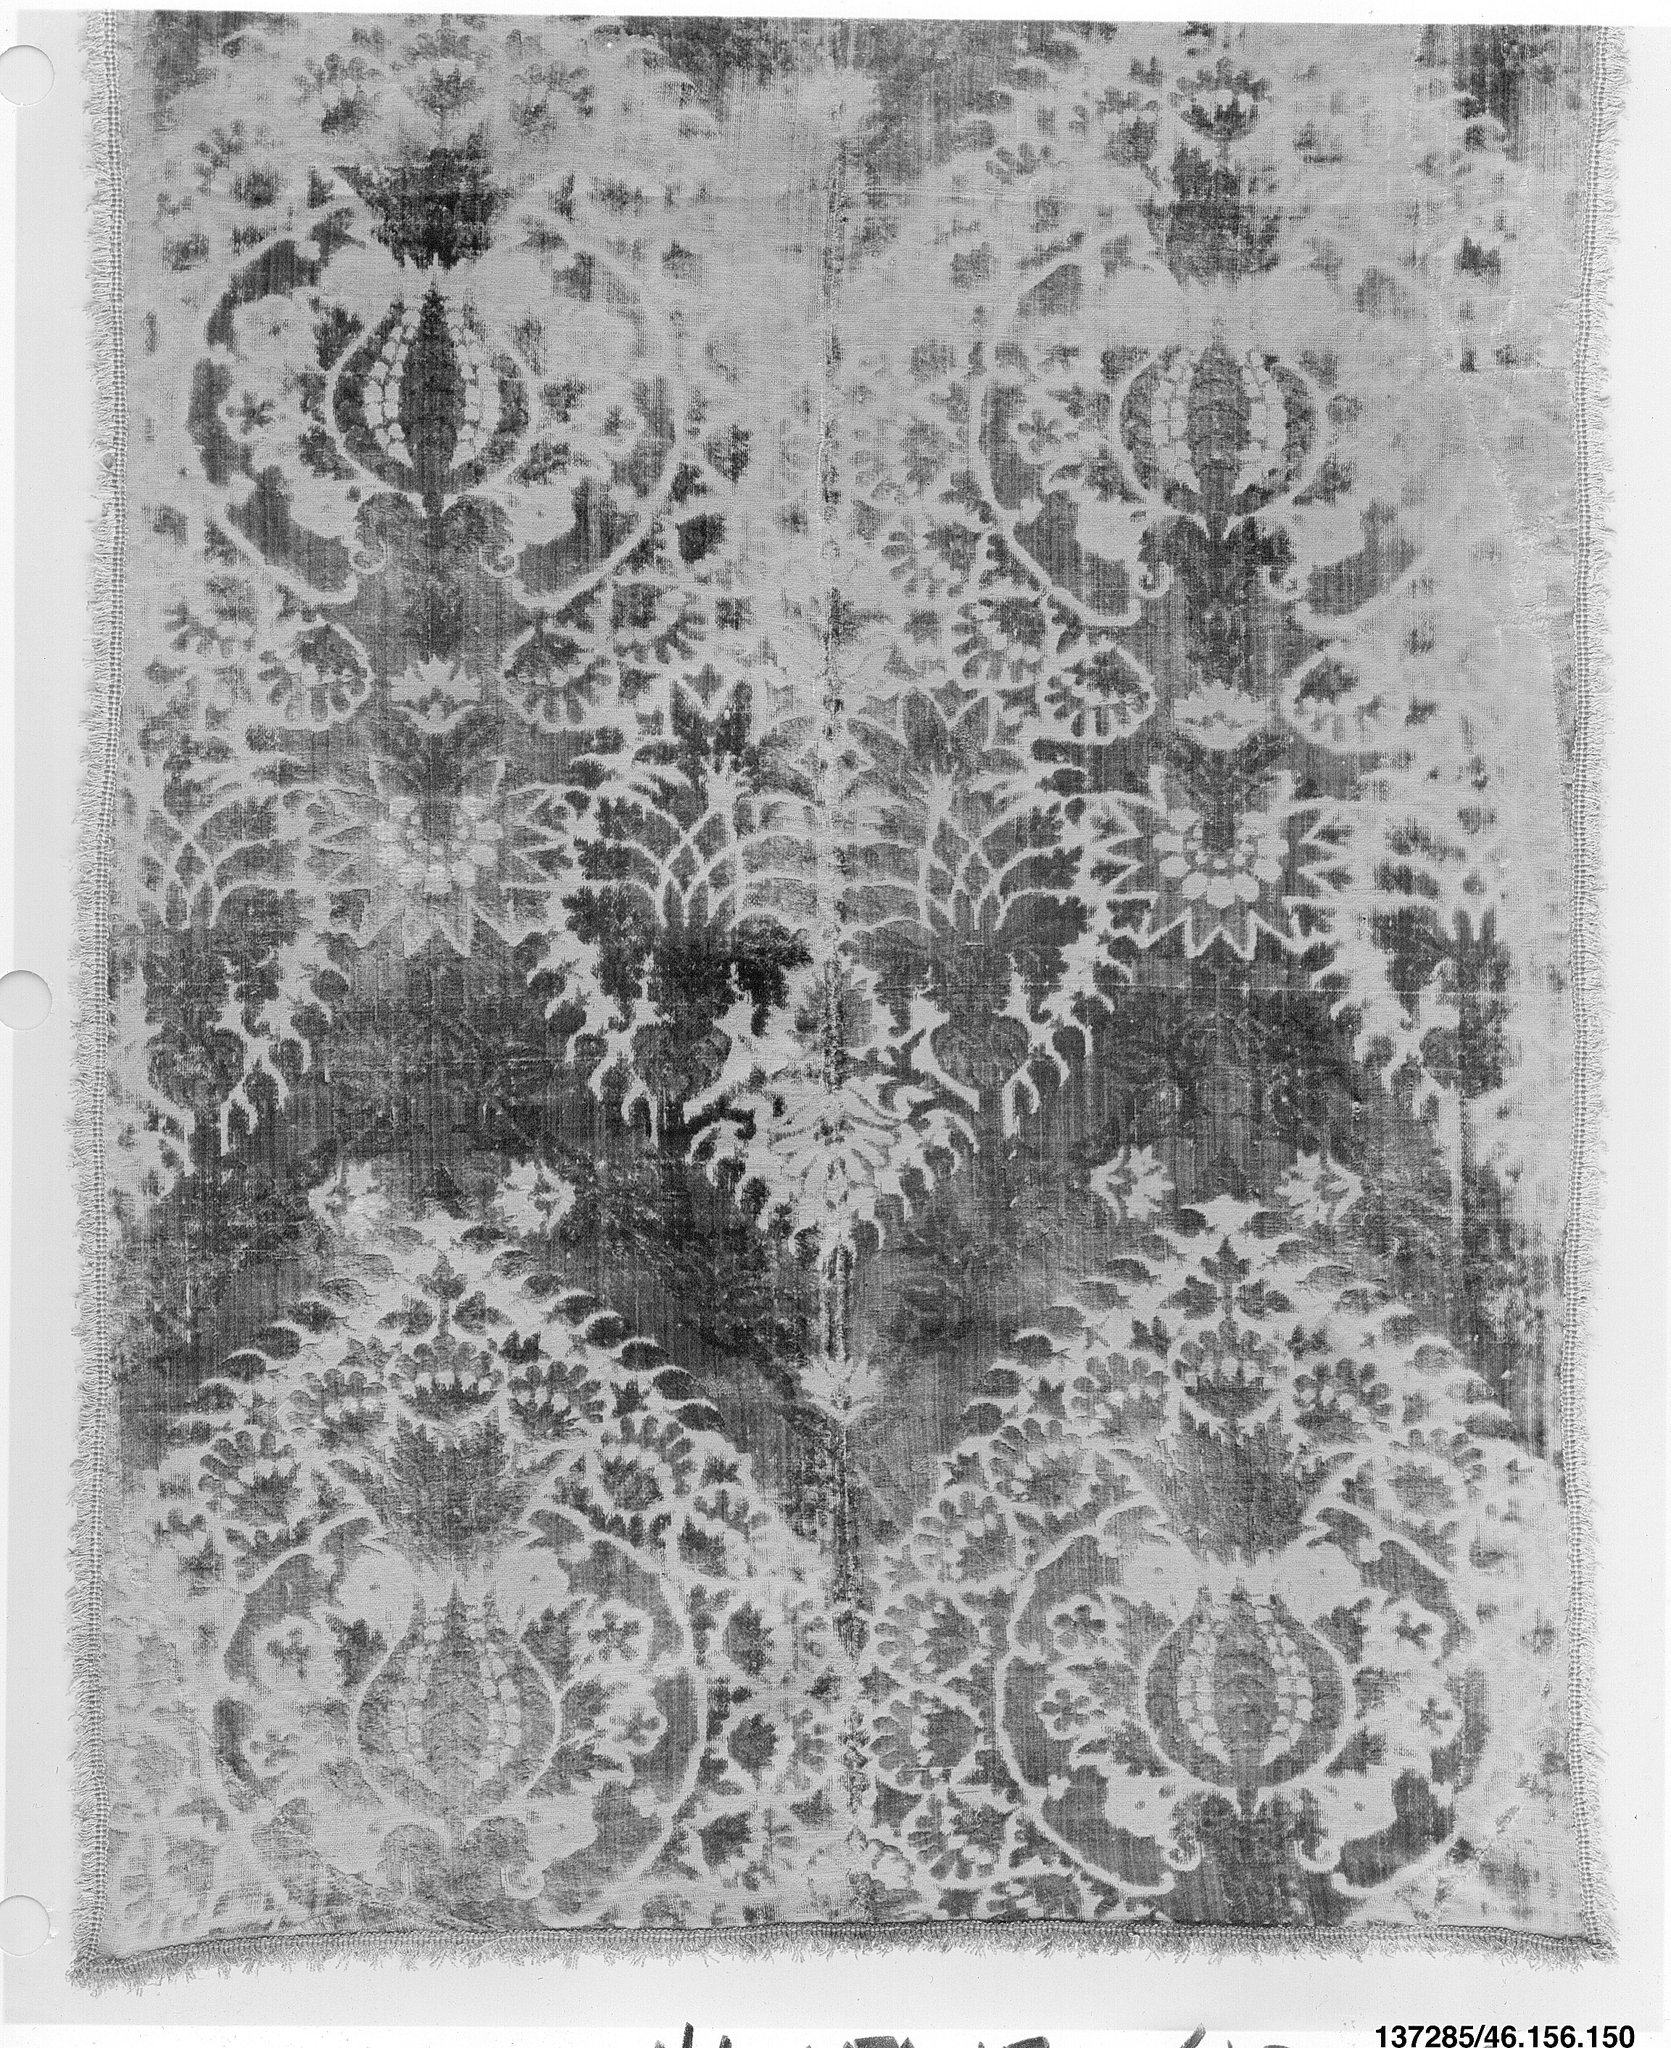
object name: panel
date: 1451-1500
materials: silk